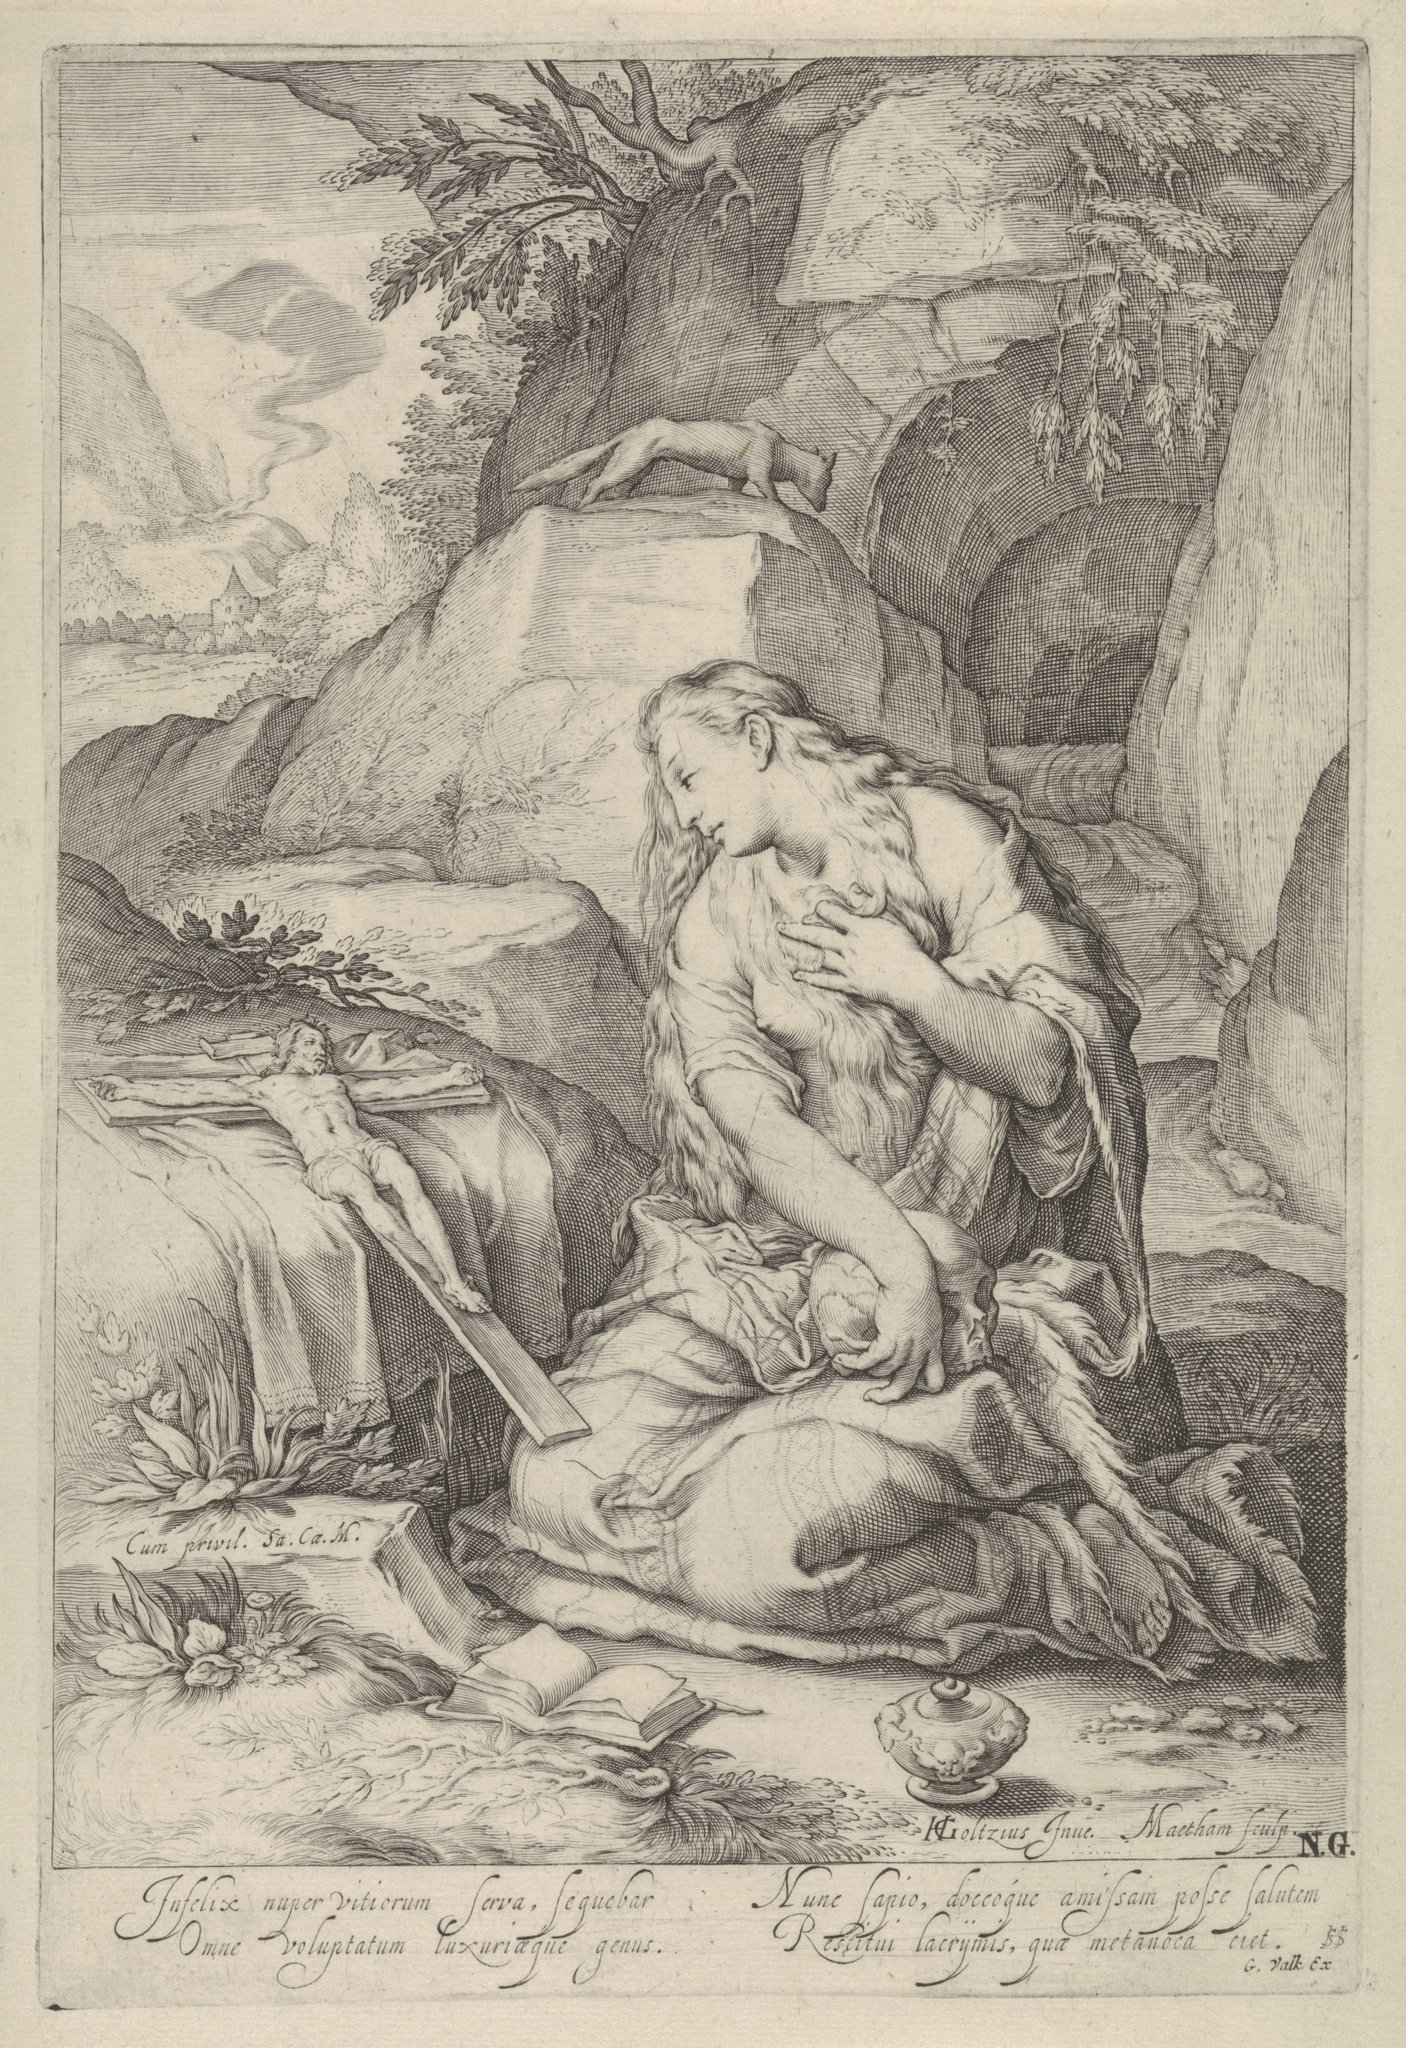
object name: print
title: Boetvaardige Maria Magdalena in landschap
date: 1694-1715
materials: paper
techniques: engraving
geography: amsterdam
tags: the penitent st. mary magdalene (often before a cave, possibly at la sainte-baume hill): her long hair covers her (naked) body, she reads, meditates or raises her tear-filled eyes towards heaven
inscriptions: collector's mark: Lugt 1967